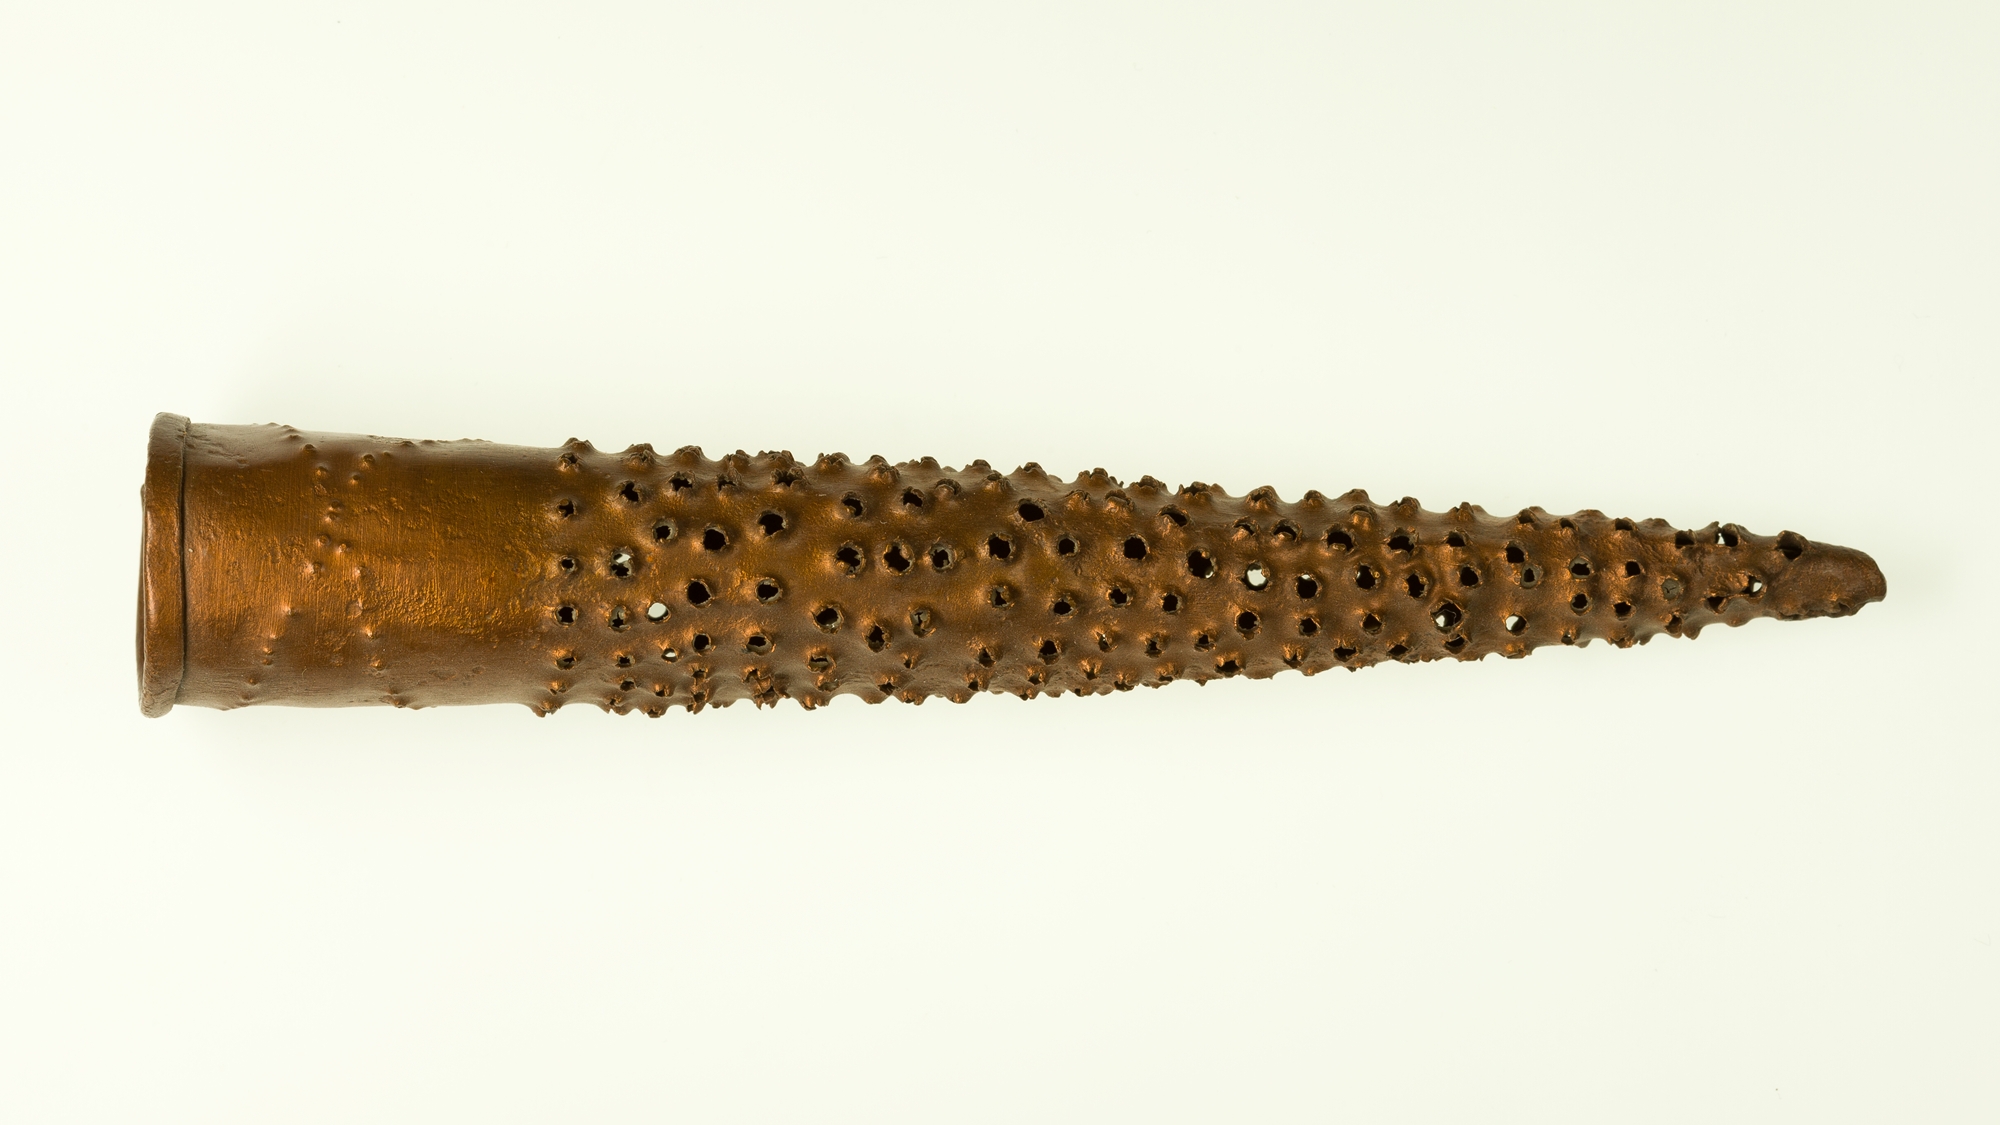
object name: siphon nozzle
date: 1295-1070 BCE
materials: bronze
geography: egypt